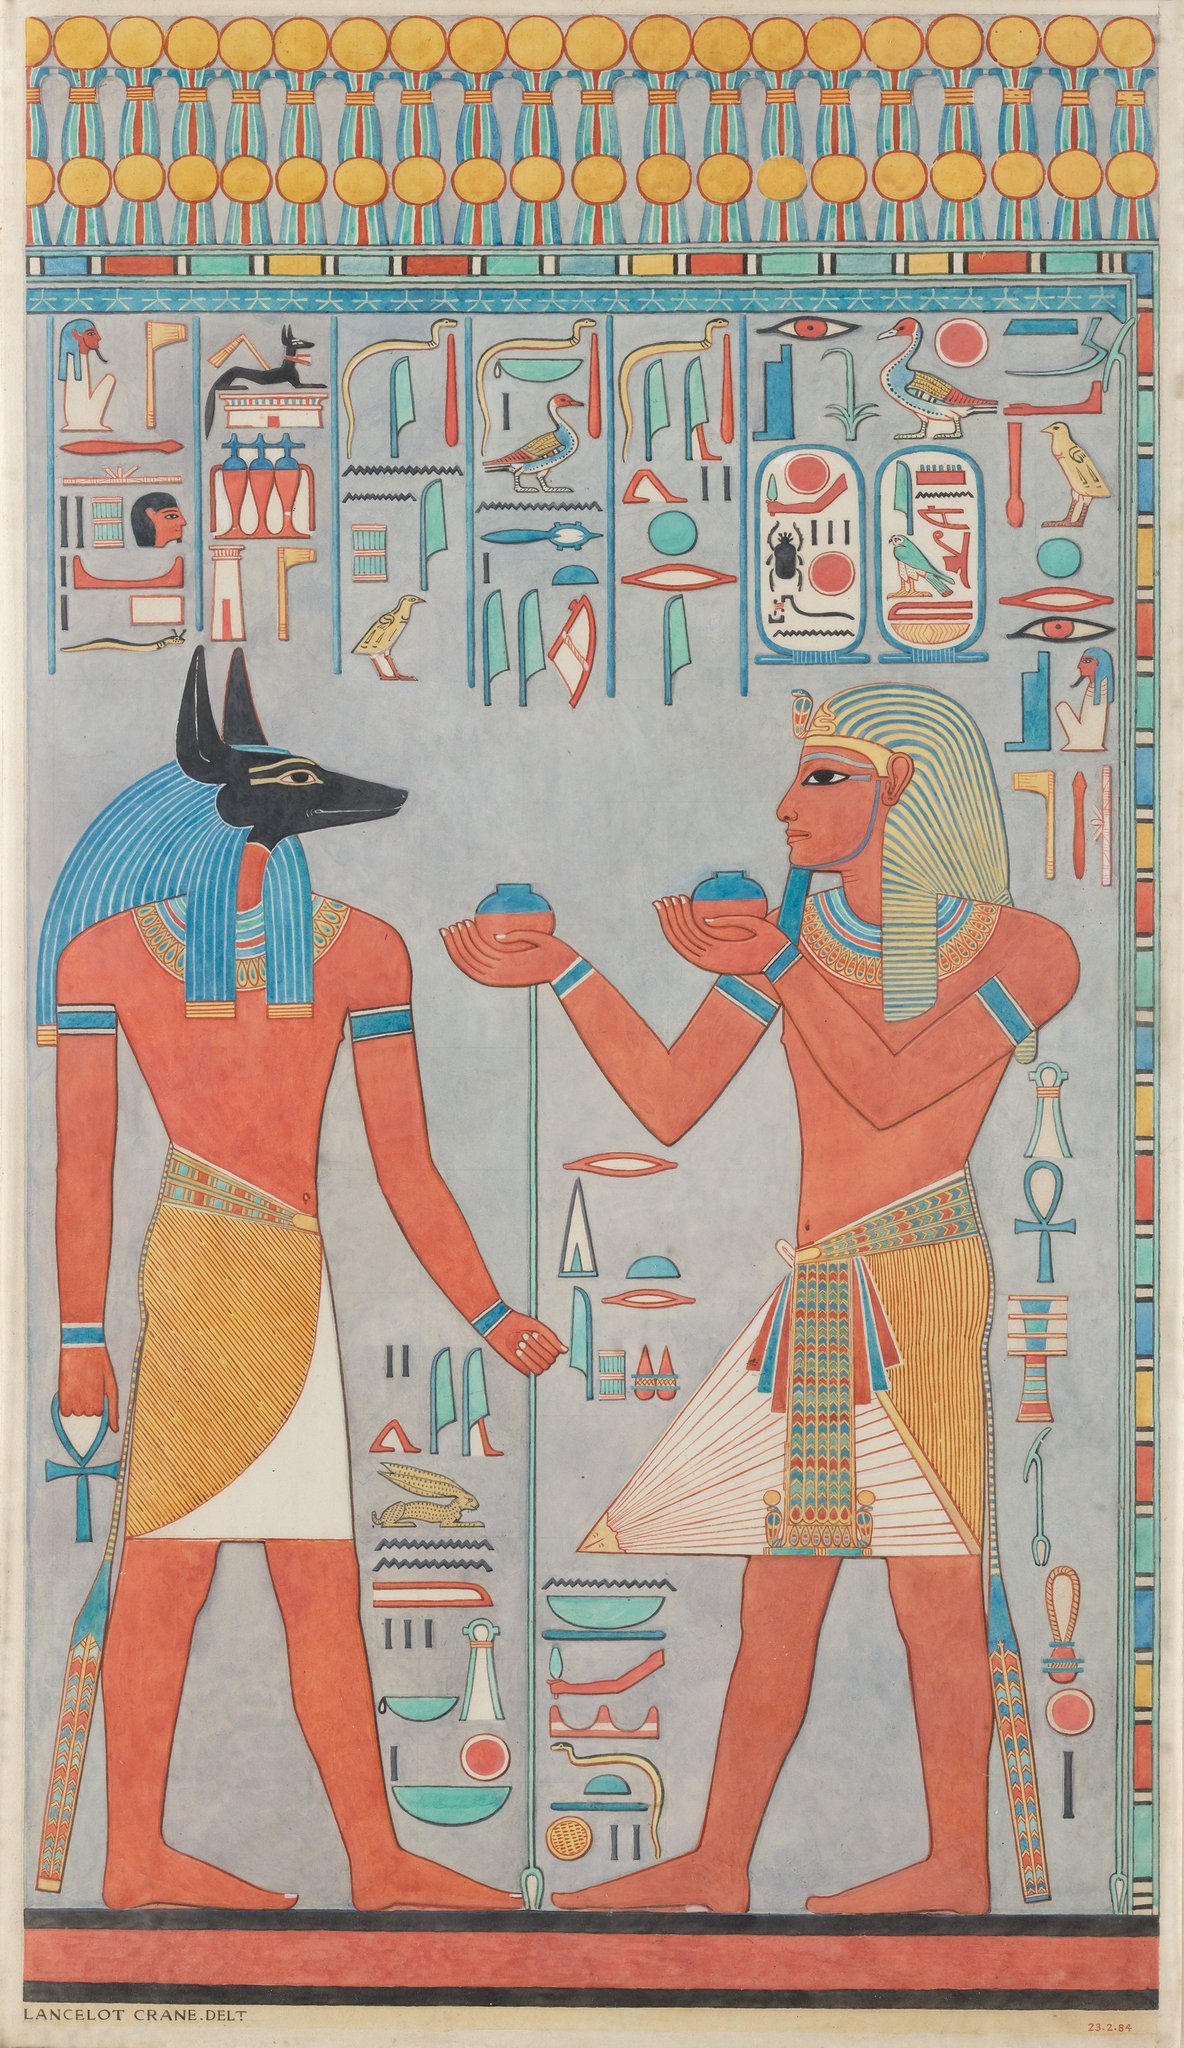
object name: facsimile, haremhab, kv 57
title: The King with Anubis, Tomb of Haremhab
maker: lancelot crane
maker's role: artist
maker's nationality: british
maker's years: 1880-1918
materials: paper, paint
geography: egypt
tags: kings,hieroglyphs,anubis